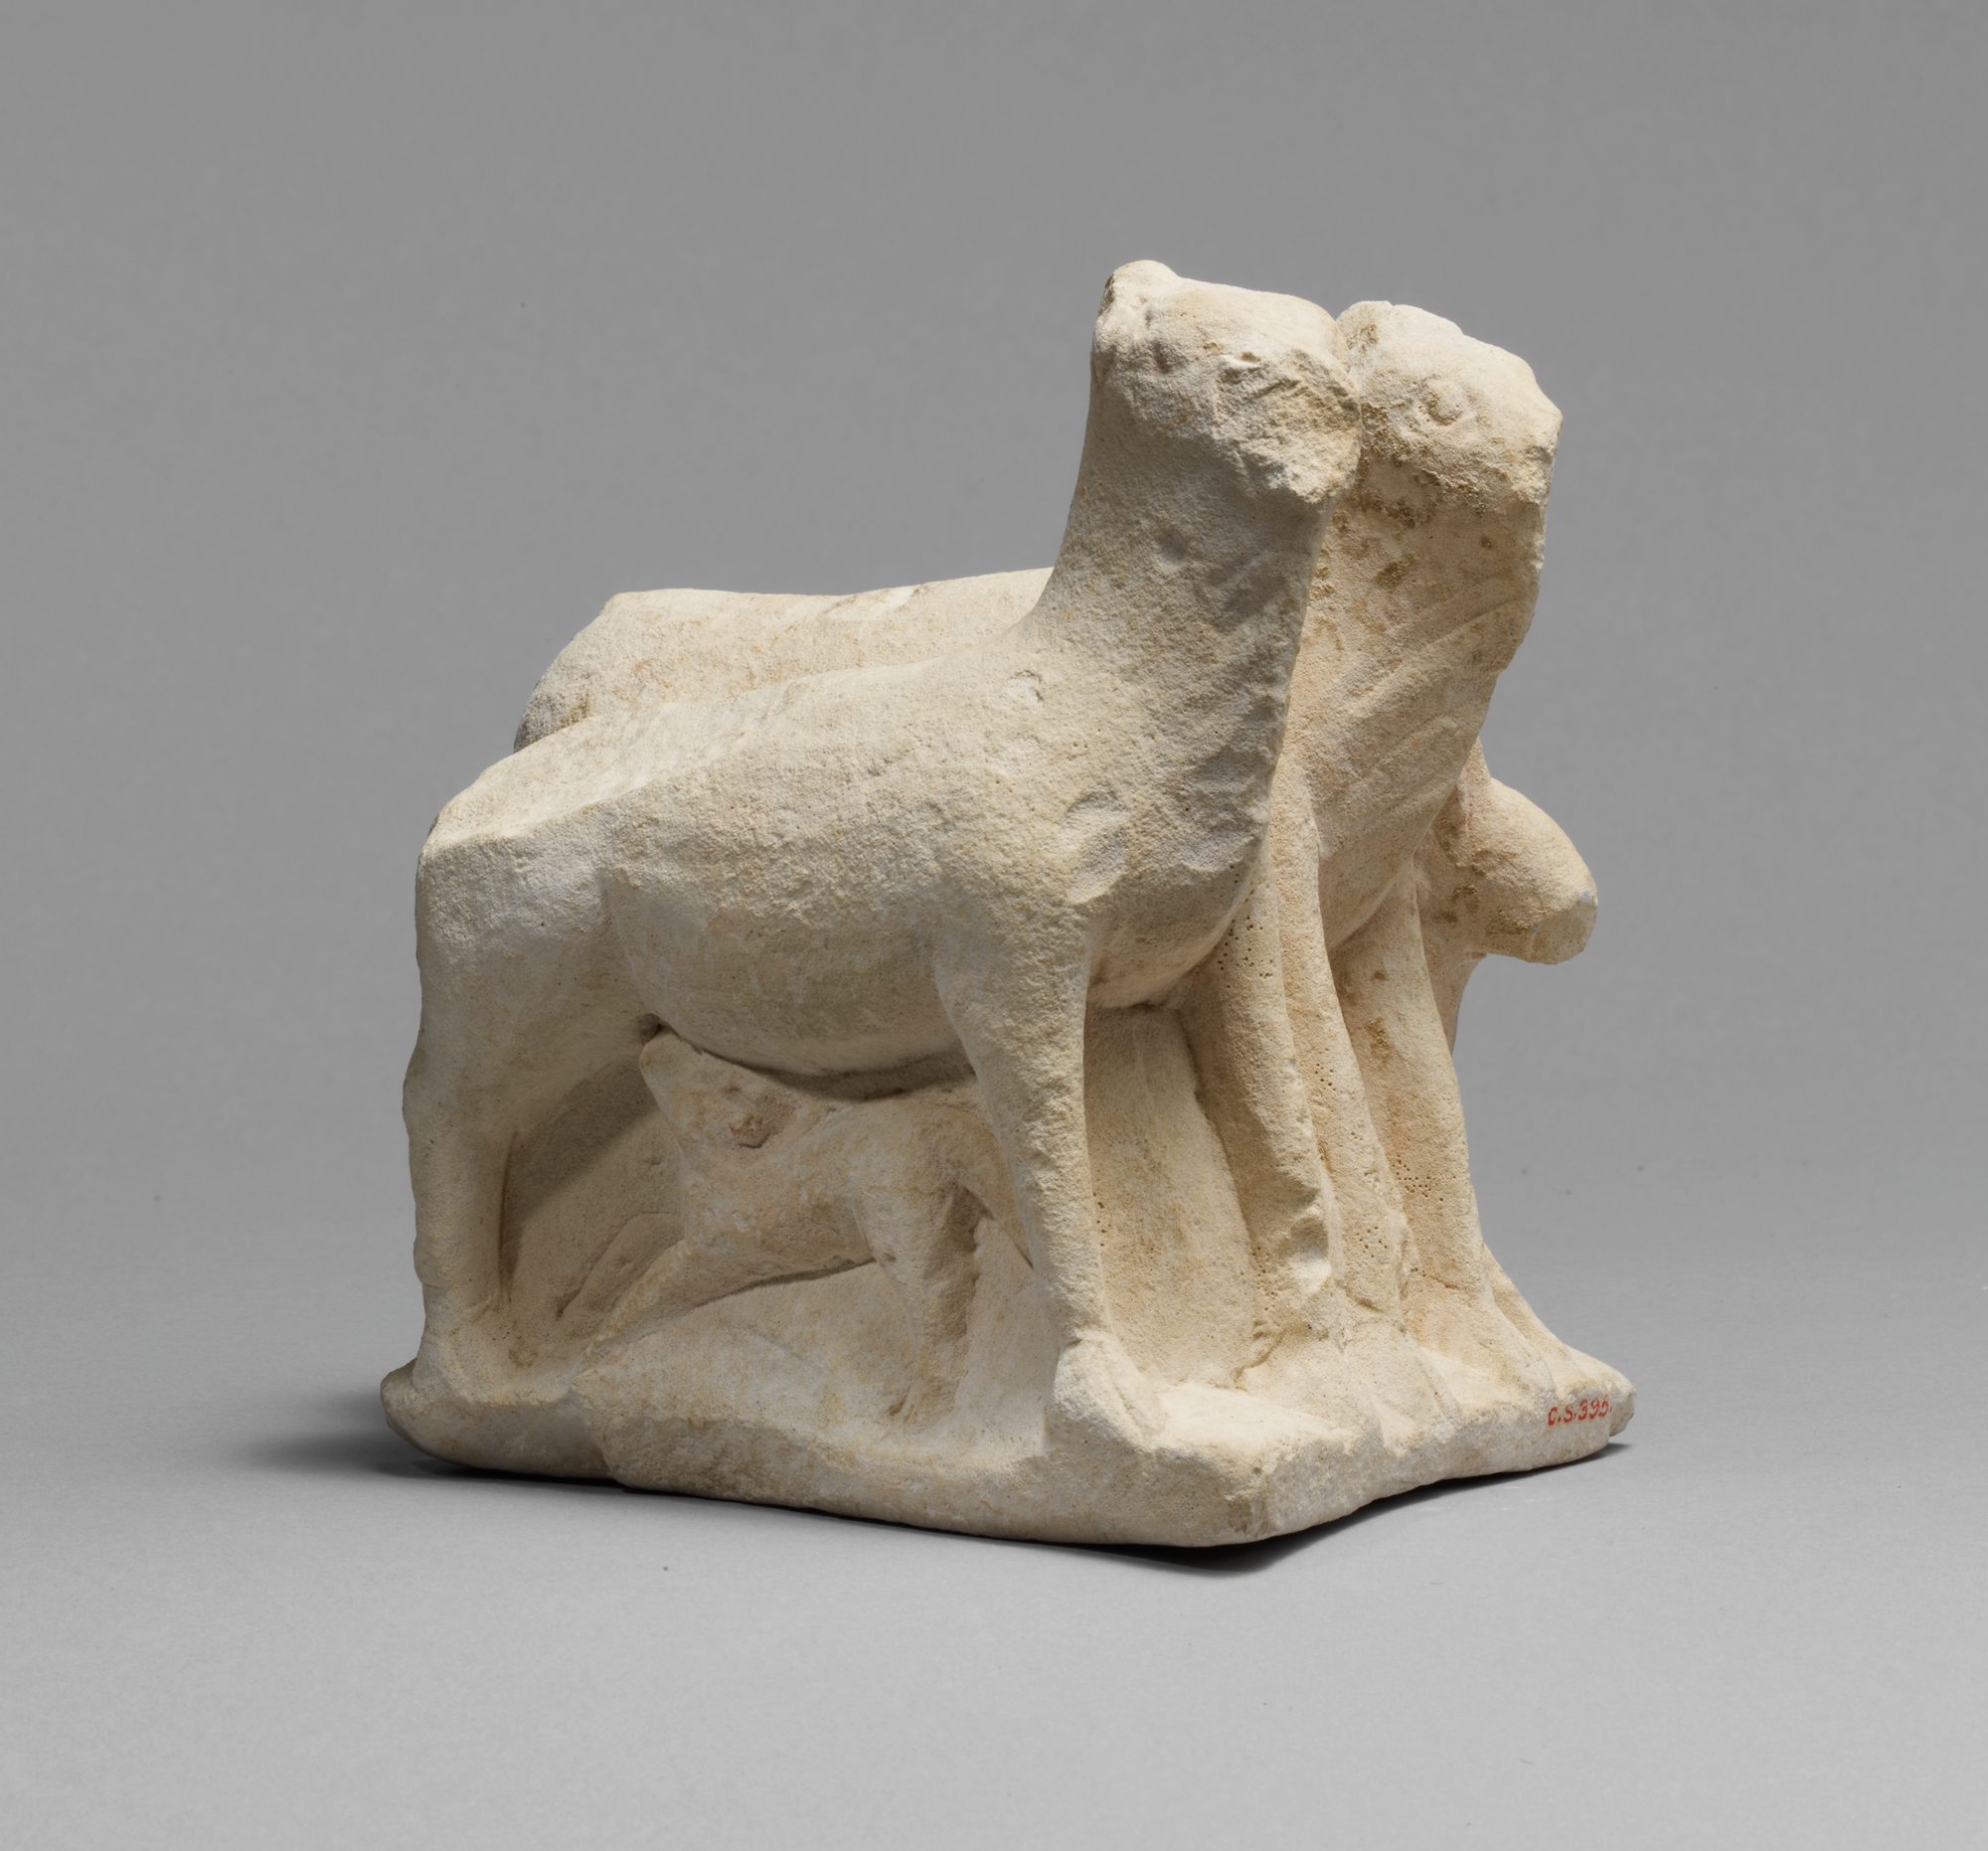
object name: statuette of a cow and calf, 2 or sheep and lamb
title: Limestone statuette of three animals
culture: cypriot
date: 600-501 BCE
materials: limestone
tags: animals